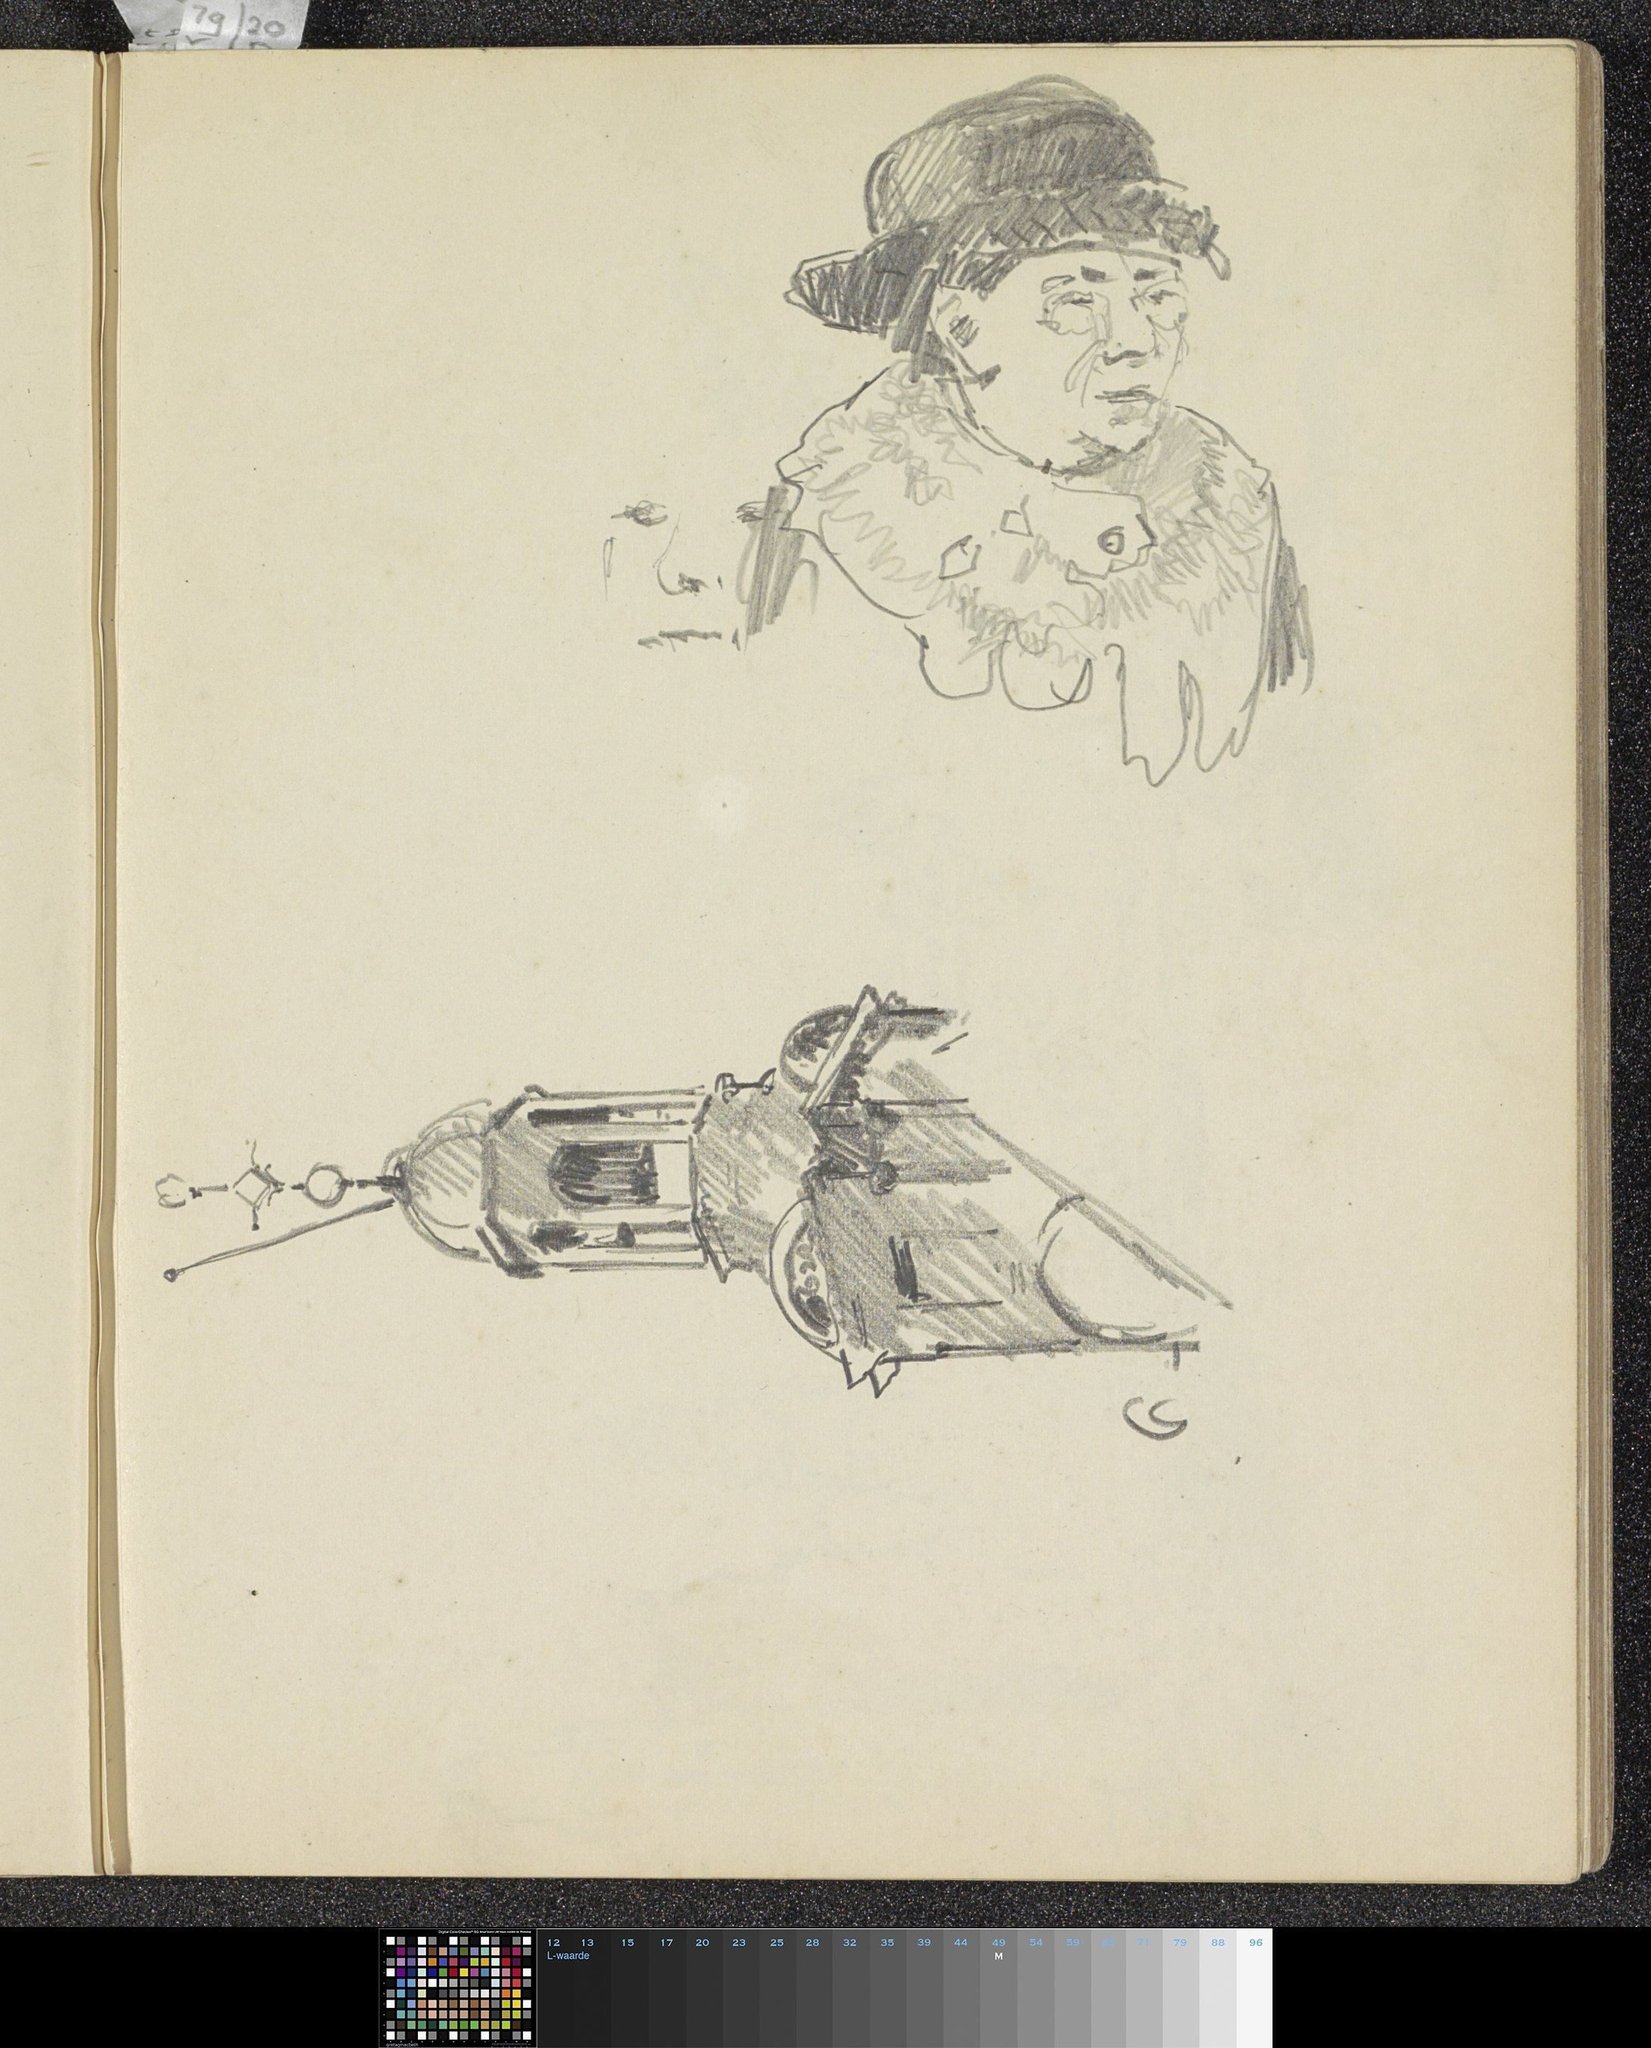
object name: sketchbook leaf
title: Kerktoren en een vrouw met een hoed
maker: cornelis vreedenburgh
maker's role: draughtsman, print maker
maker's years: 1880-1946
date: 1890-1946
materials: paper, pencil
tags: adult woman, parts of church exterior and annexes: tower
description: Blad 16 recto uit een schetsboek met 76 bladen.